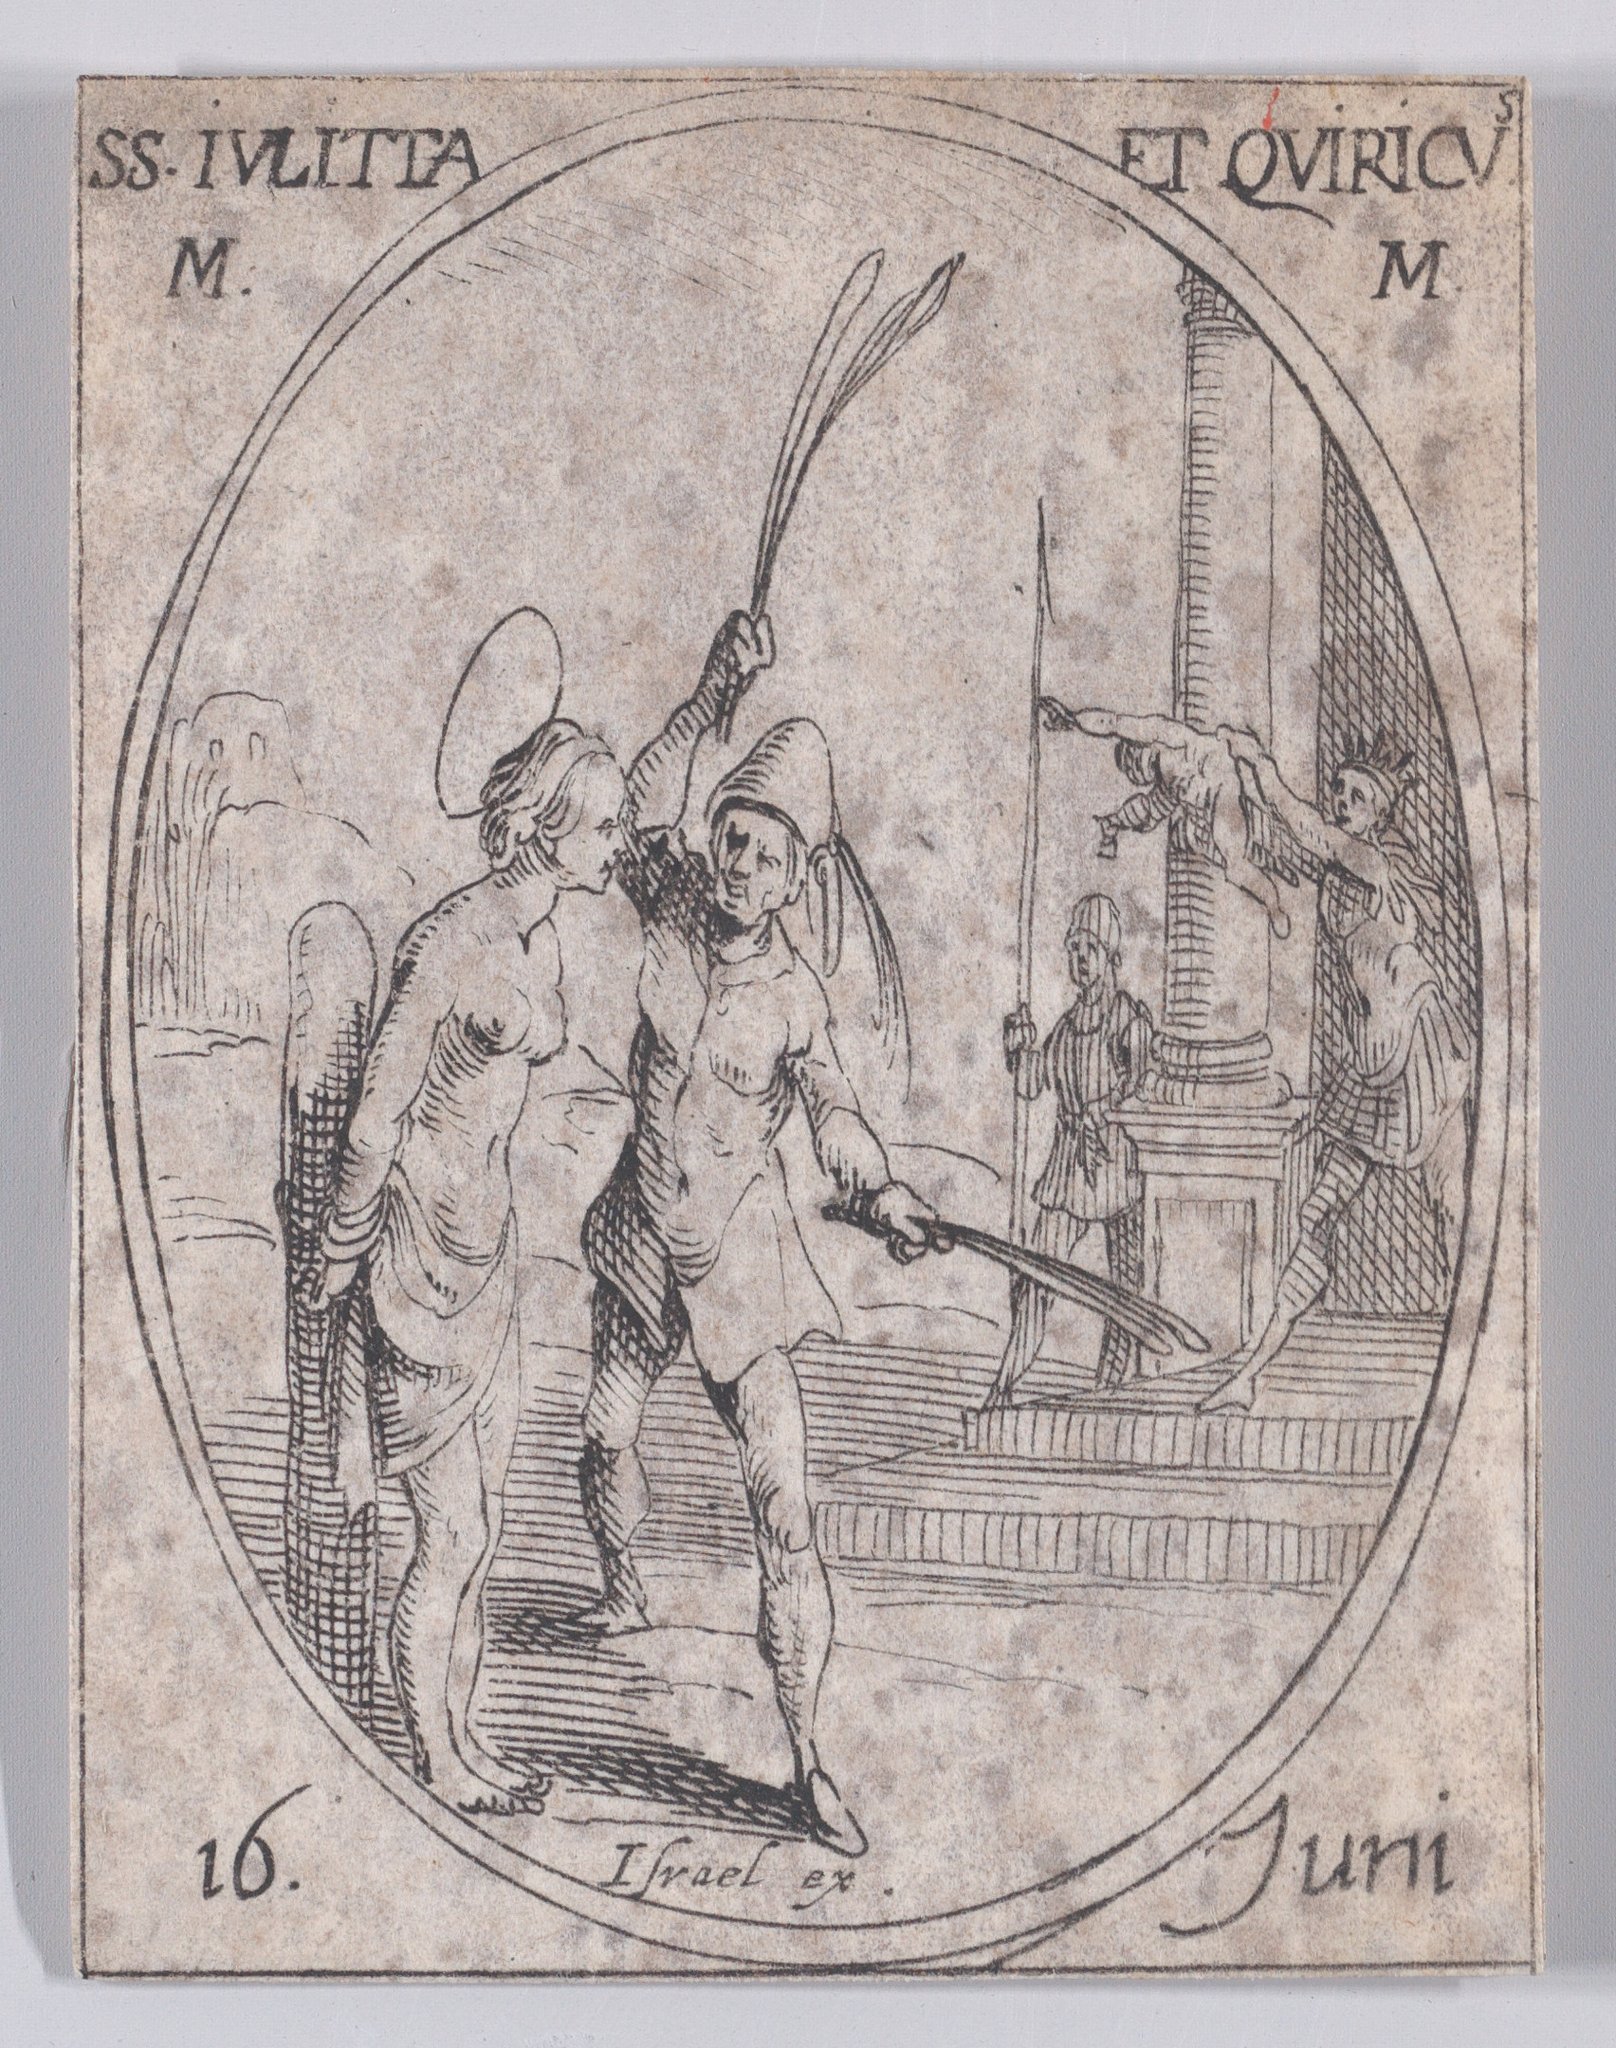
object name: print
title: Ste. Juliette et S. Quirie, martyres (St. Julietta and St. Quiricus, Martyrs), June 16th, from "Les Images De Tous Les Saincts et Saintes de L'Année" (Images of All of the Saints and Religious Events of the Year)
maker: jacques callot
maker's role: artist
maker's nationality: french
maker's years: 1592-1635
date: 1636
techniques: etching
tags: men,women,saints